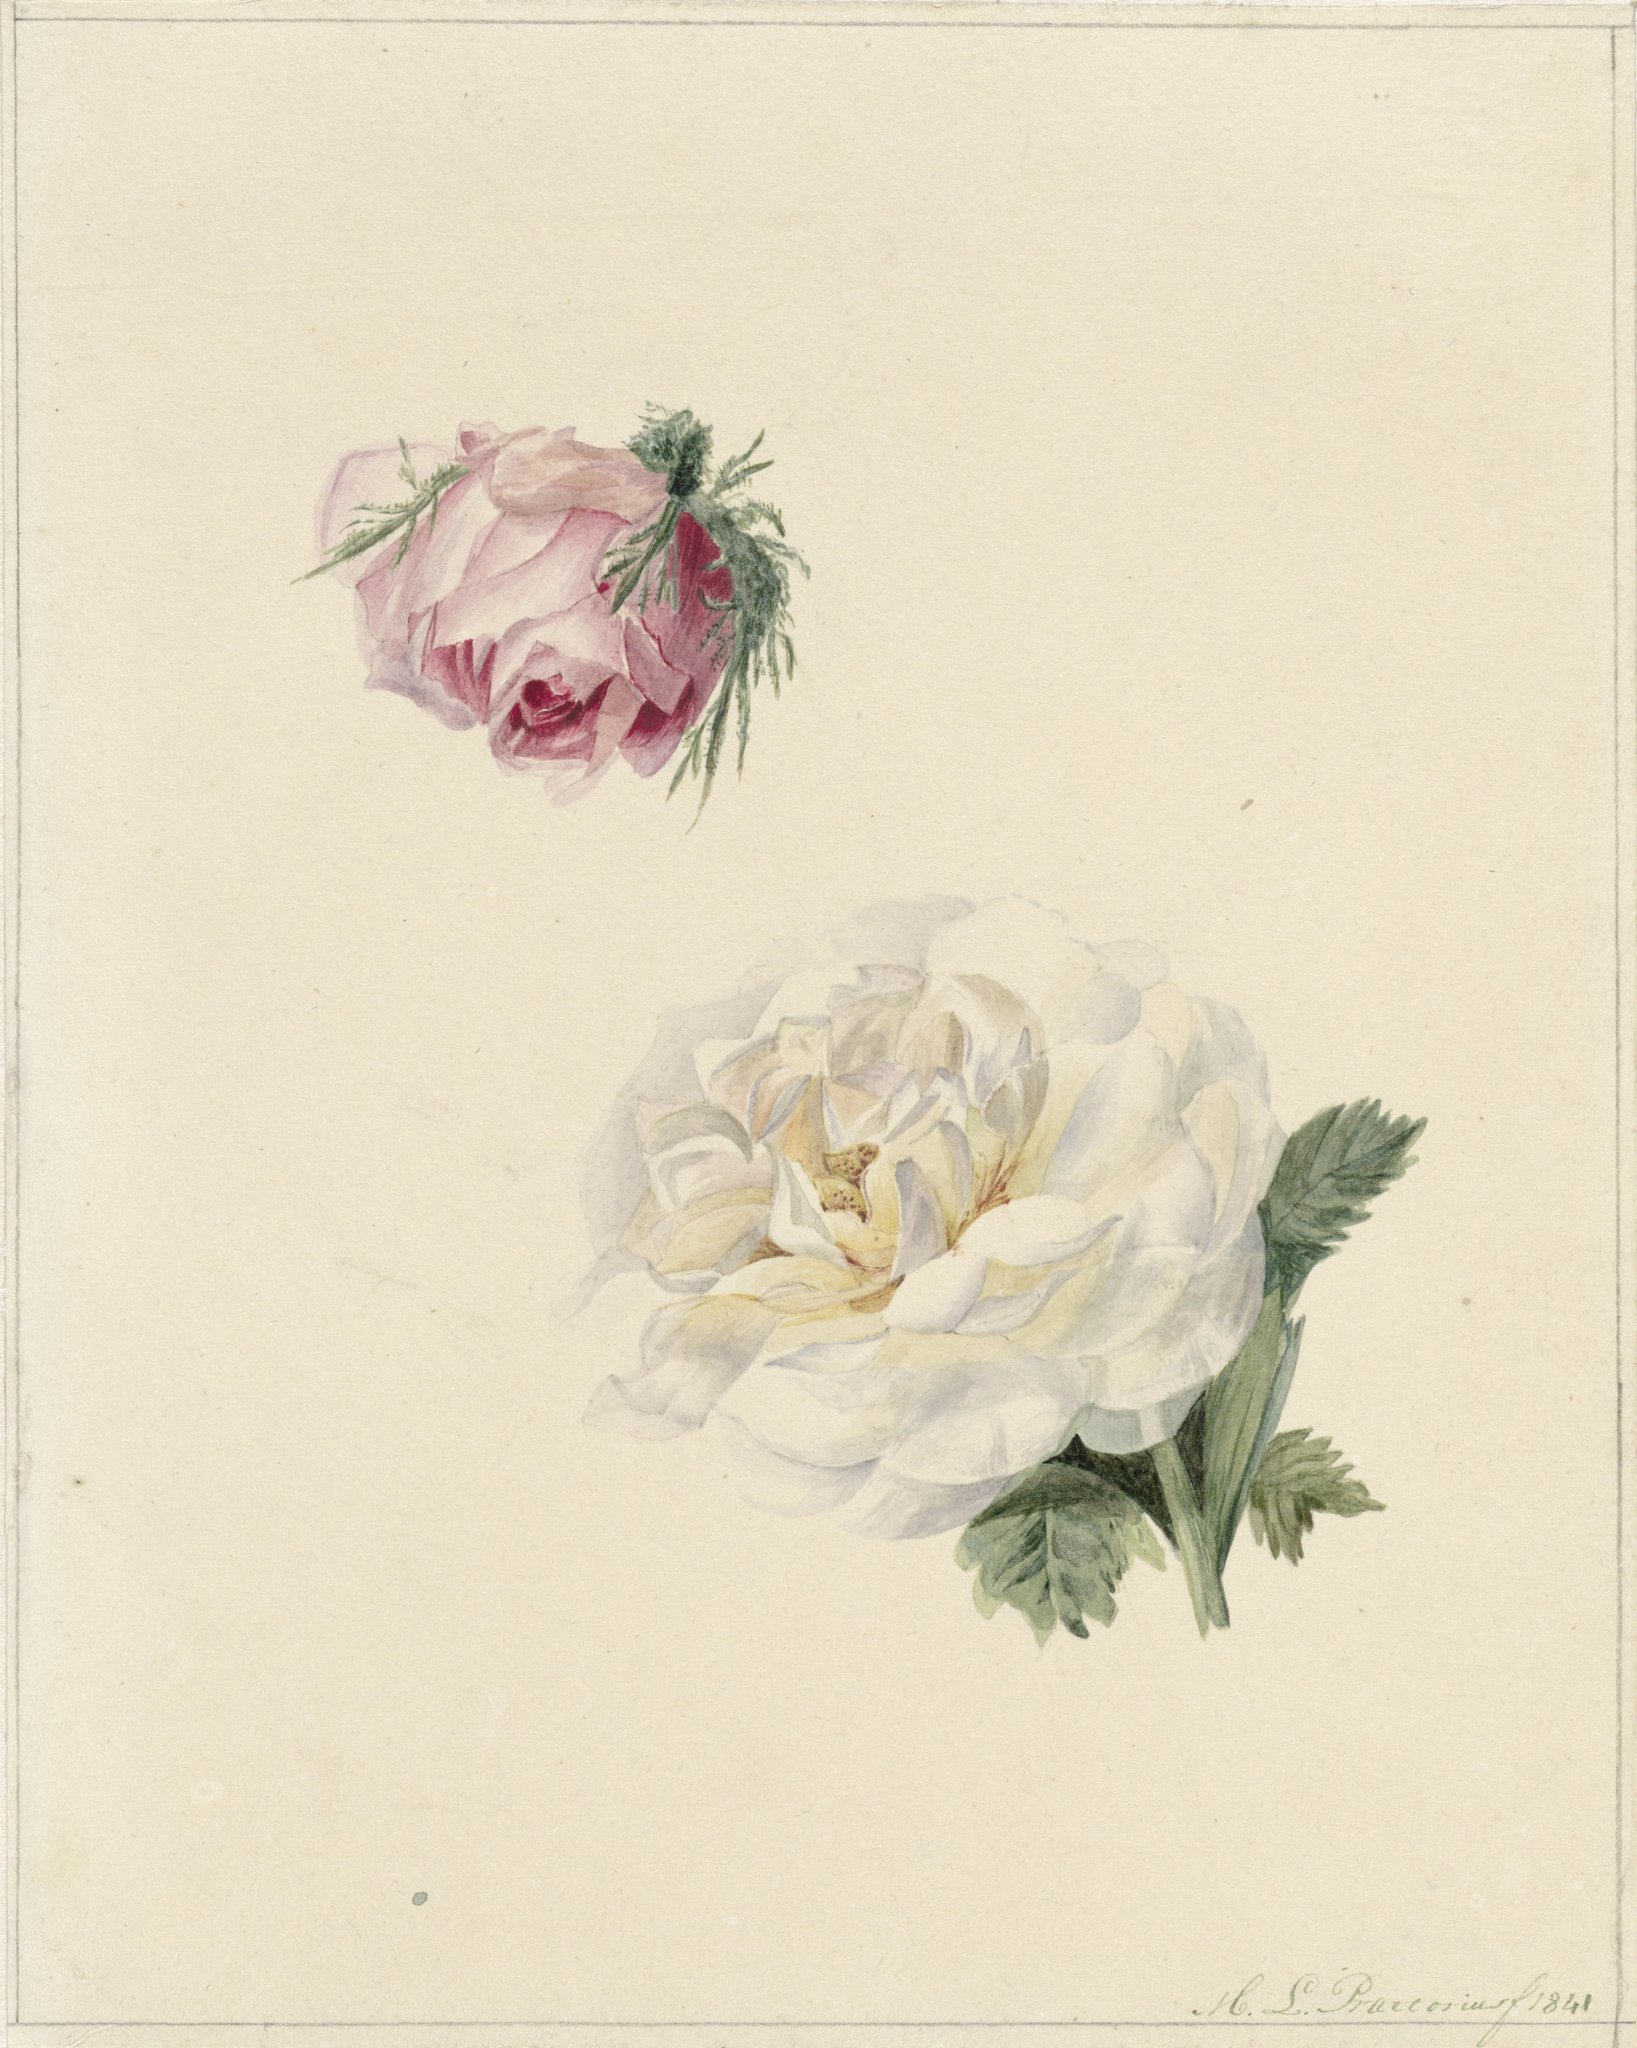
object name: watercolor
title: Studies van een roze en een witte roos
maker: marie louise praetorius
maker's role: draughtsman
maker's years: 1821-1850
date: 1841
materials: paper, pencil, watercolor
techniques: brush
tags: flowers: rose